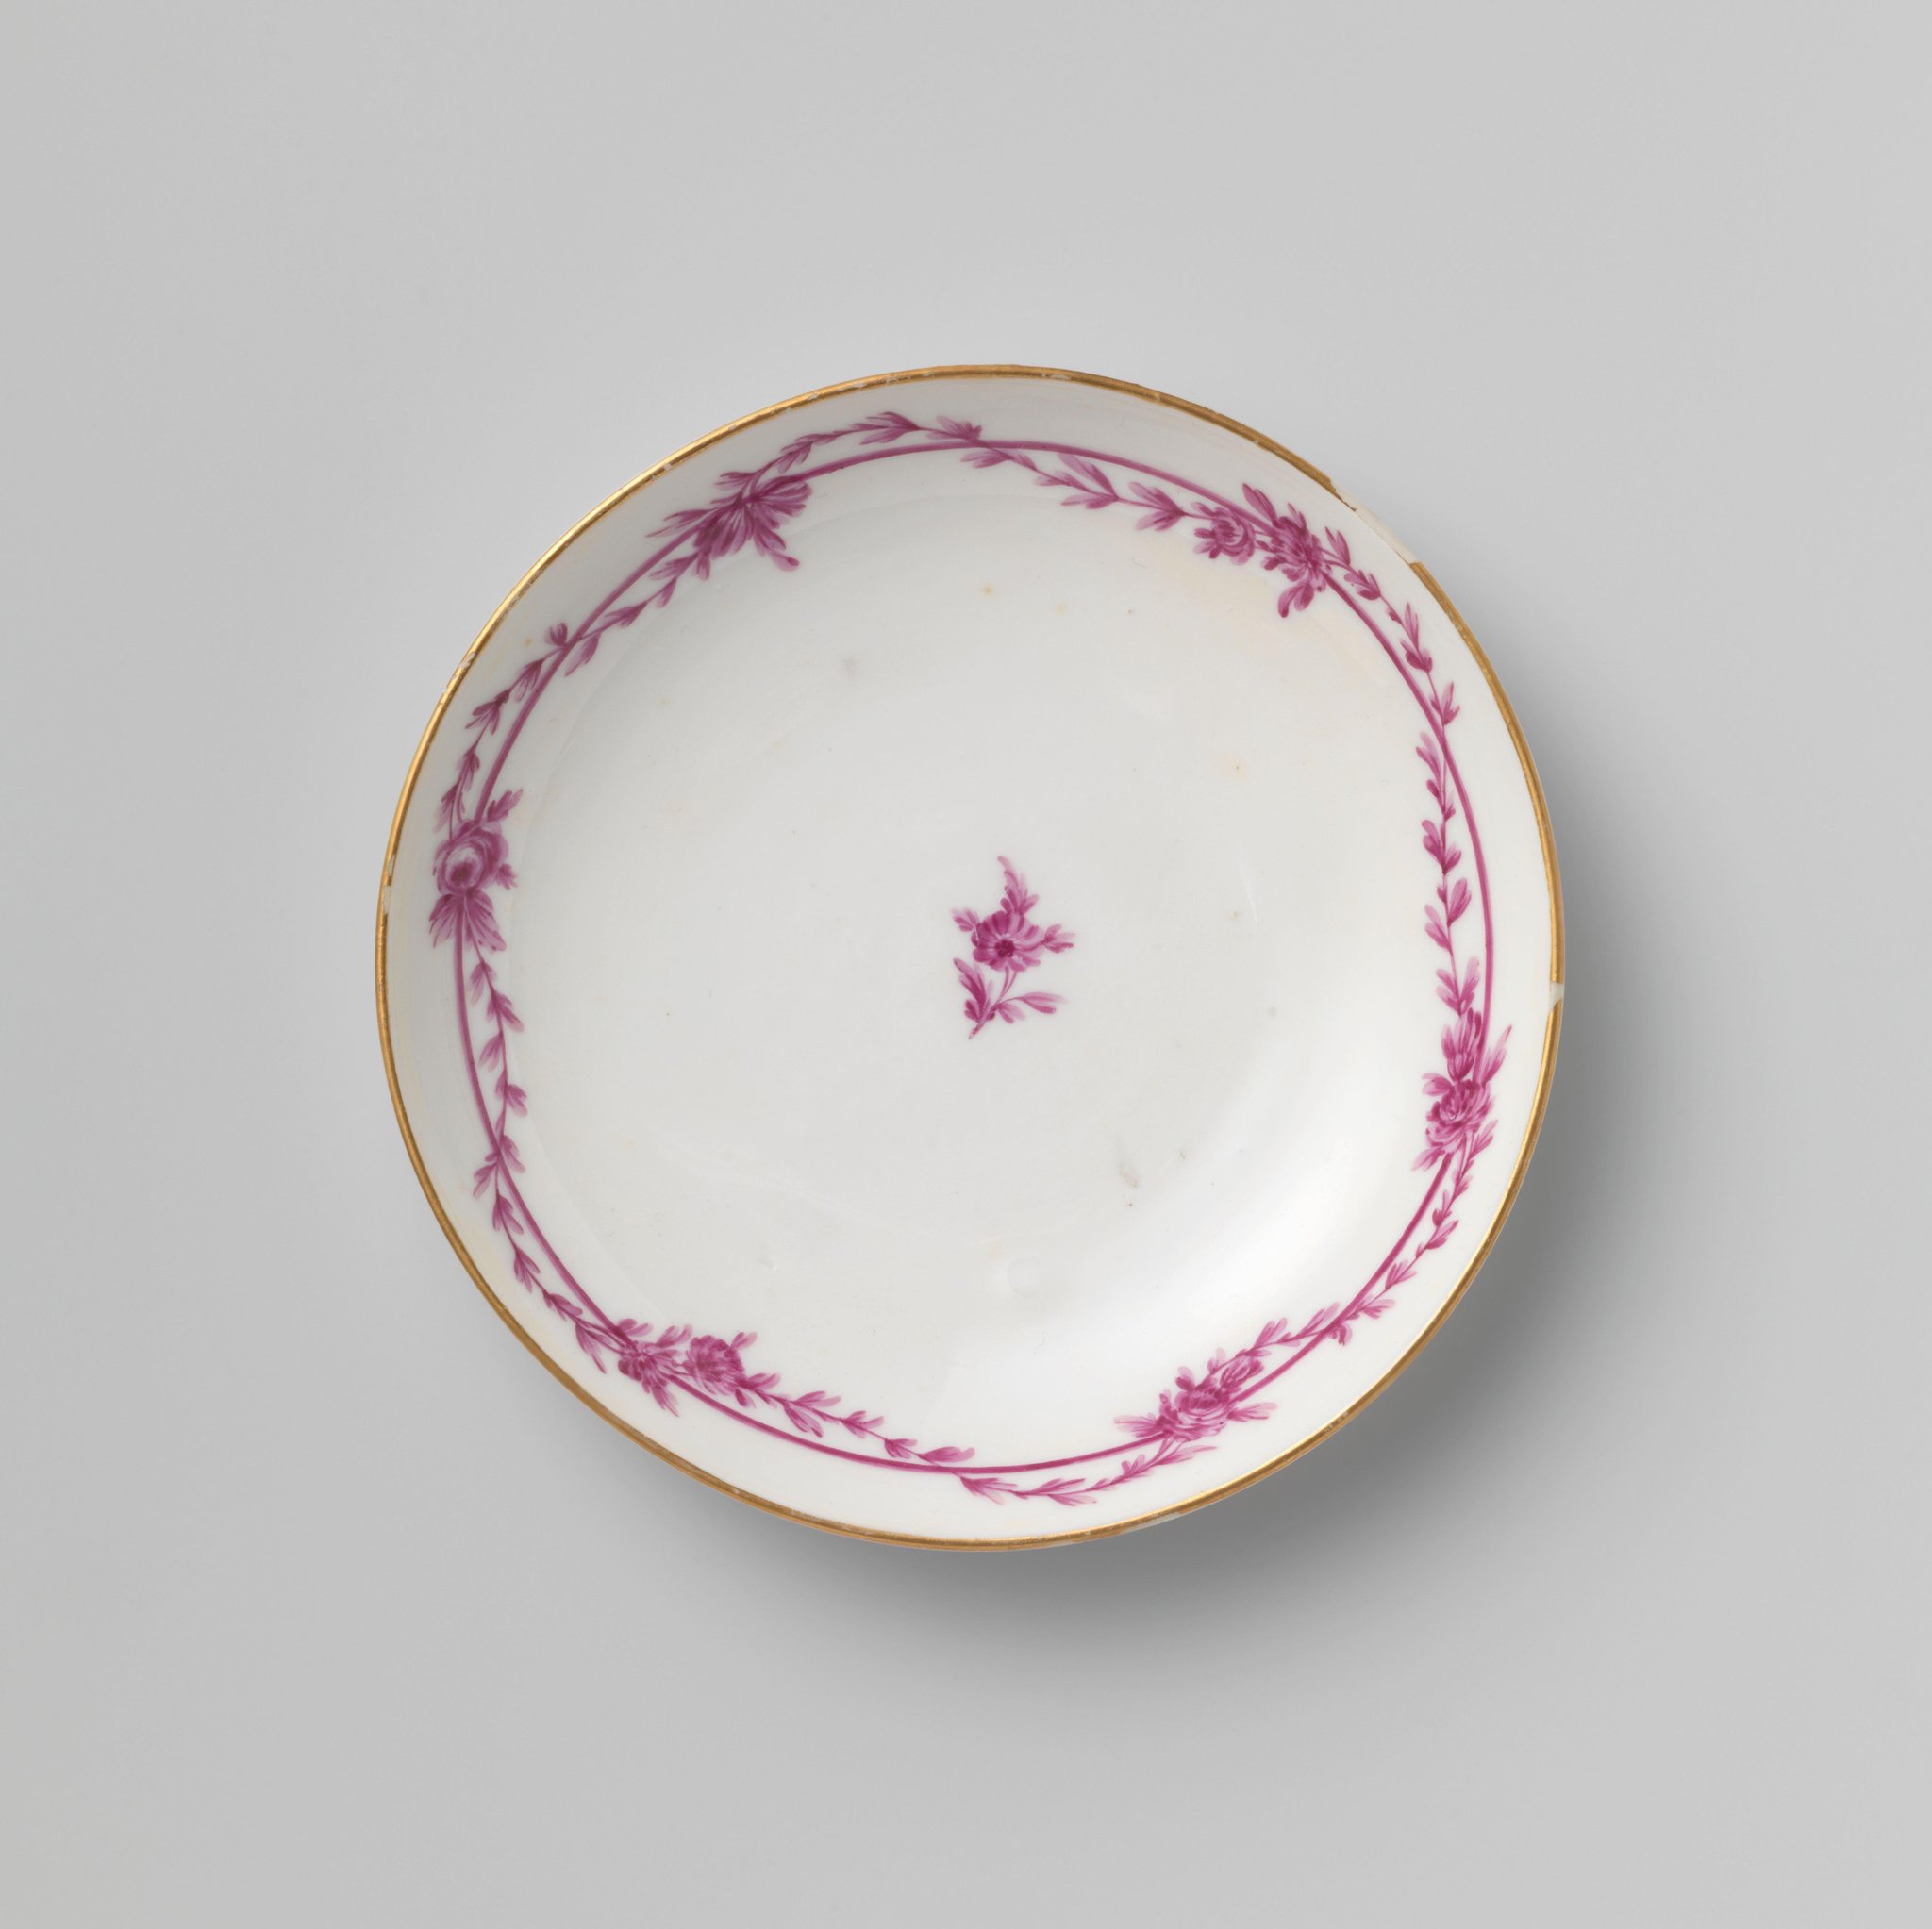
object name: kop en schotel, kop en schotel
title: Schotel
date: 1780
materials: porcelain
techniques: painted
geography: loosdrecht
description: Schotel van porselein, versierd in bietenrood met een om een doorlopende bies geslingerde bloem- en bladslinger. De randen zijn verguld. Versierd met strooibloempjes in bietenrood. Gemerkt M.O.L. met ster in onderglazuurblauw.